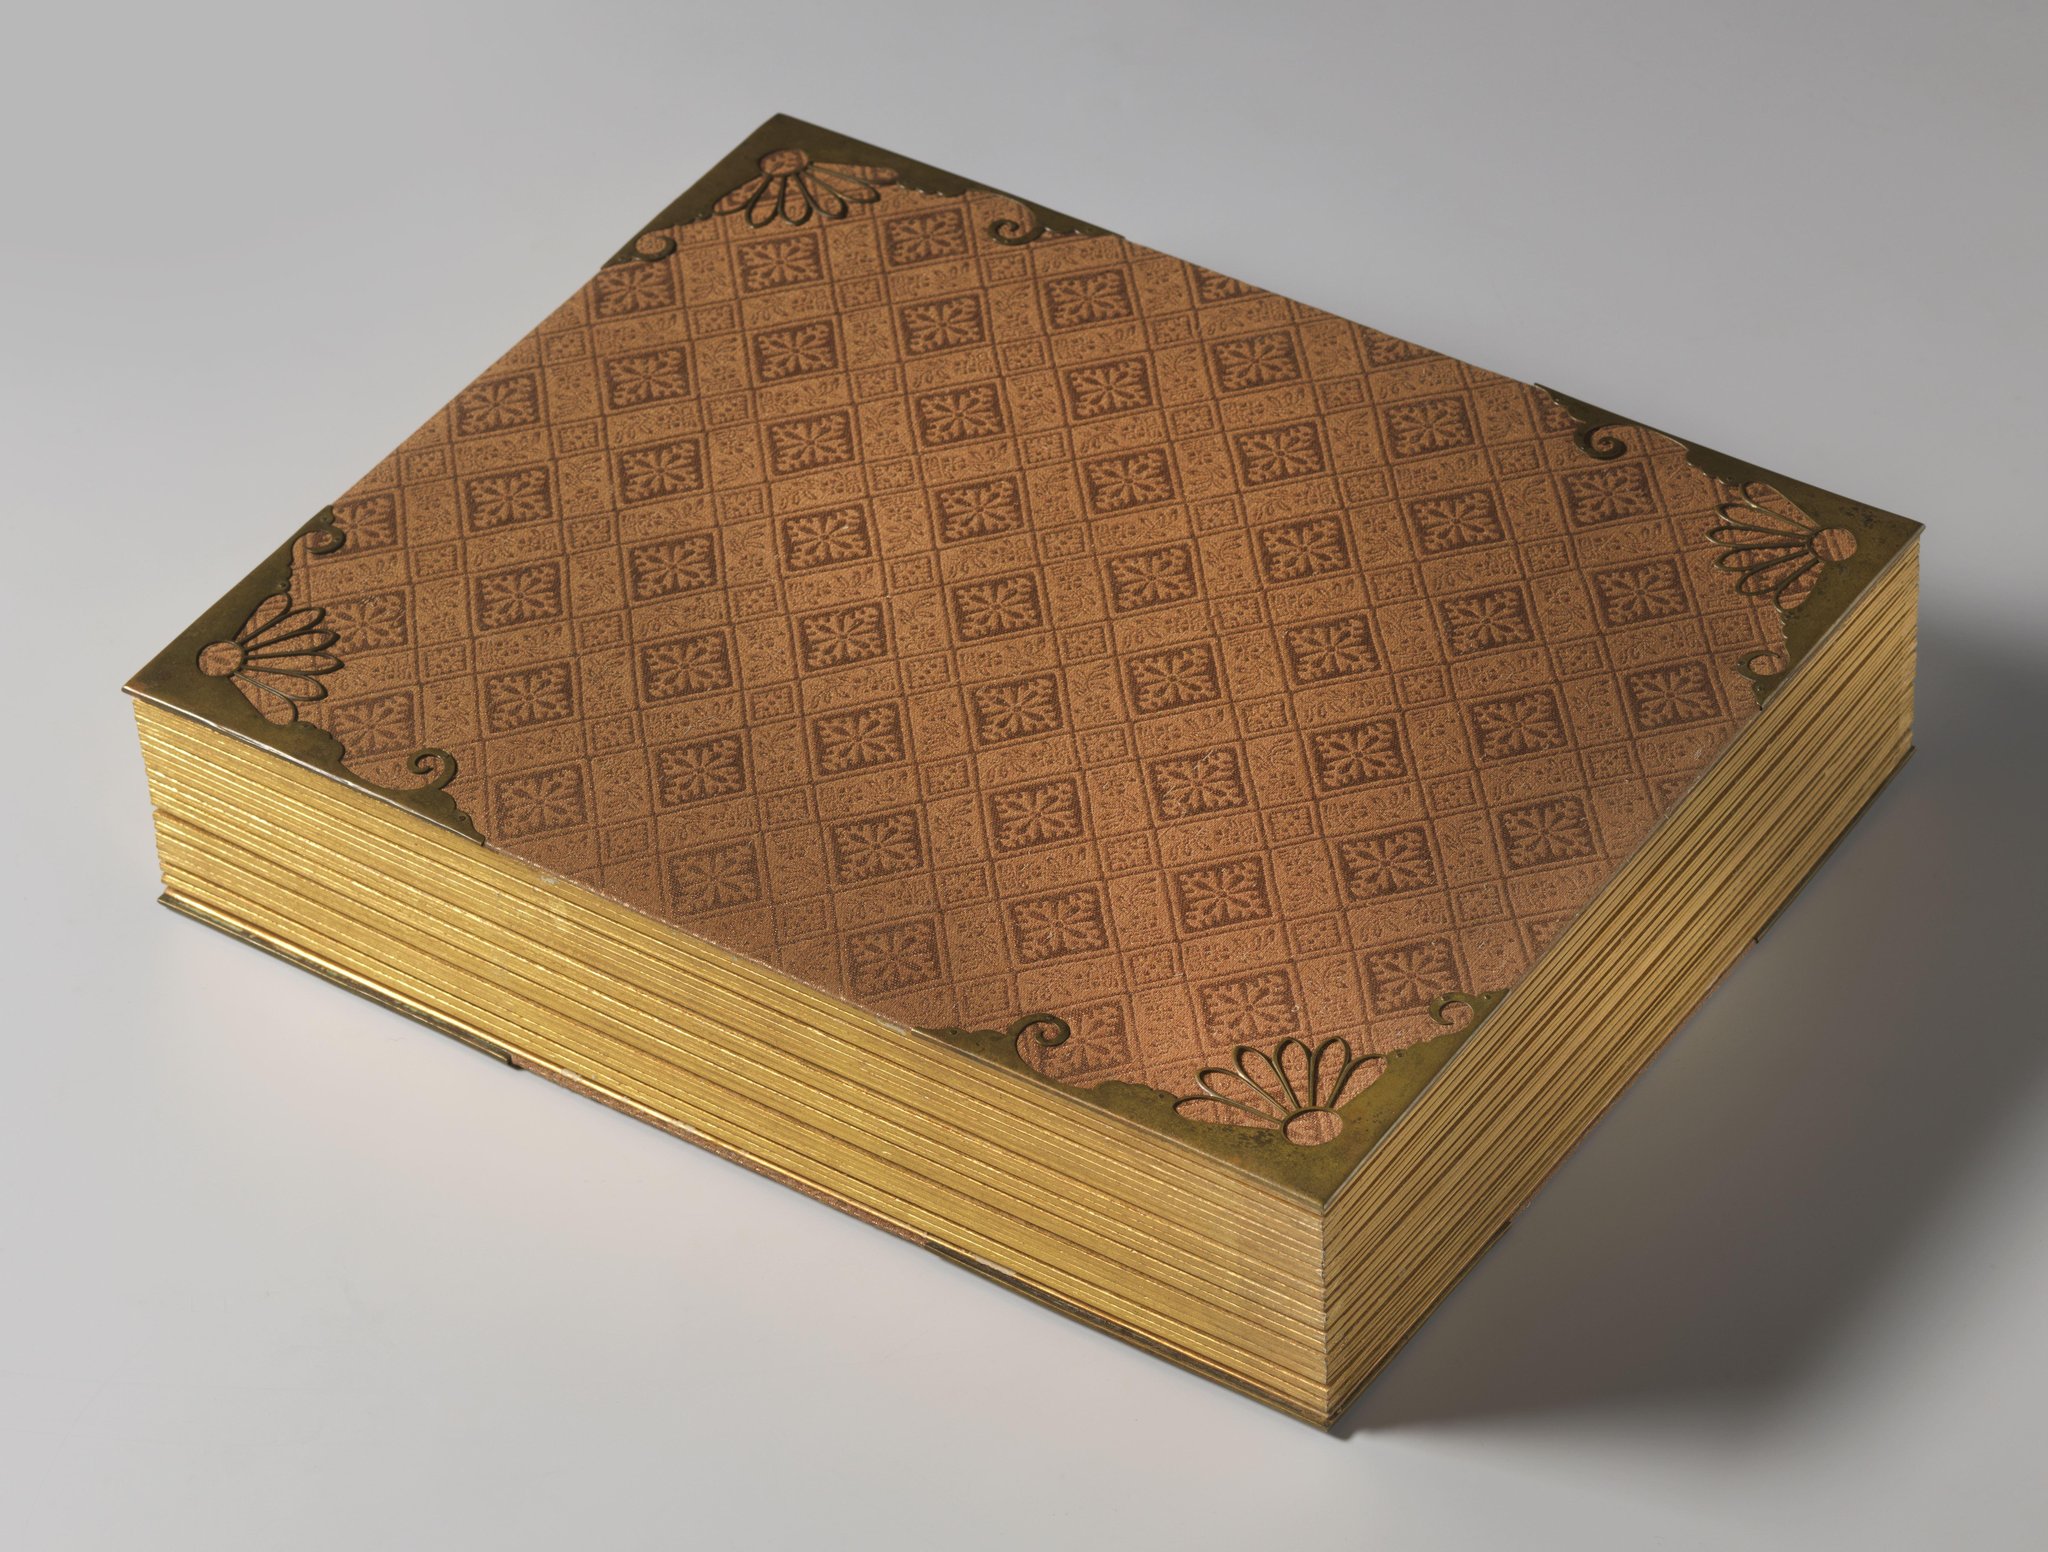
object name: album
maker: kano yasunobu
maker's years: 1613-1685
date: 1700-1900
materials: ink, paper, wood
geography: japan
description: Album met bladen, waarop de 36 beroemdste dichters van Japan zijn afgebeeld alsmede een voorbeeld van hun gedichten. Hierin bevinden zich ook twee documenten, waarvan één gedateerd 1702. Toegeschreven aan Kano Yasunobu (1613-1685)